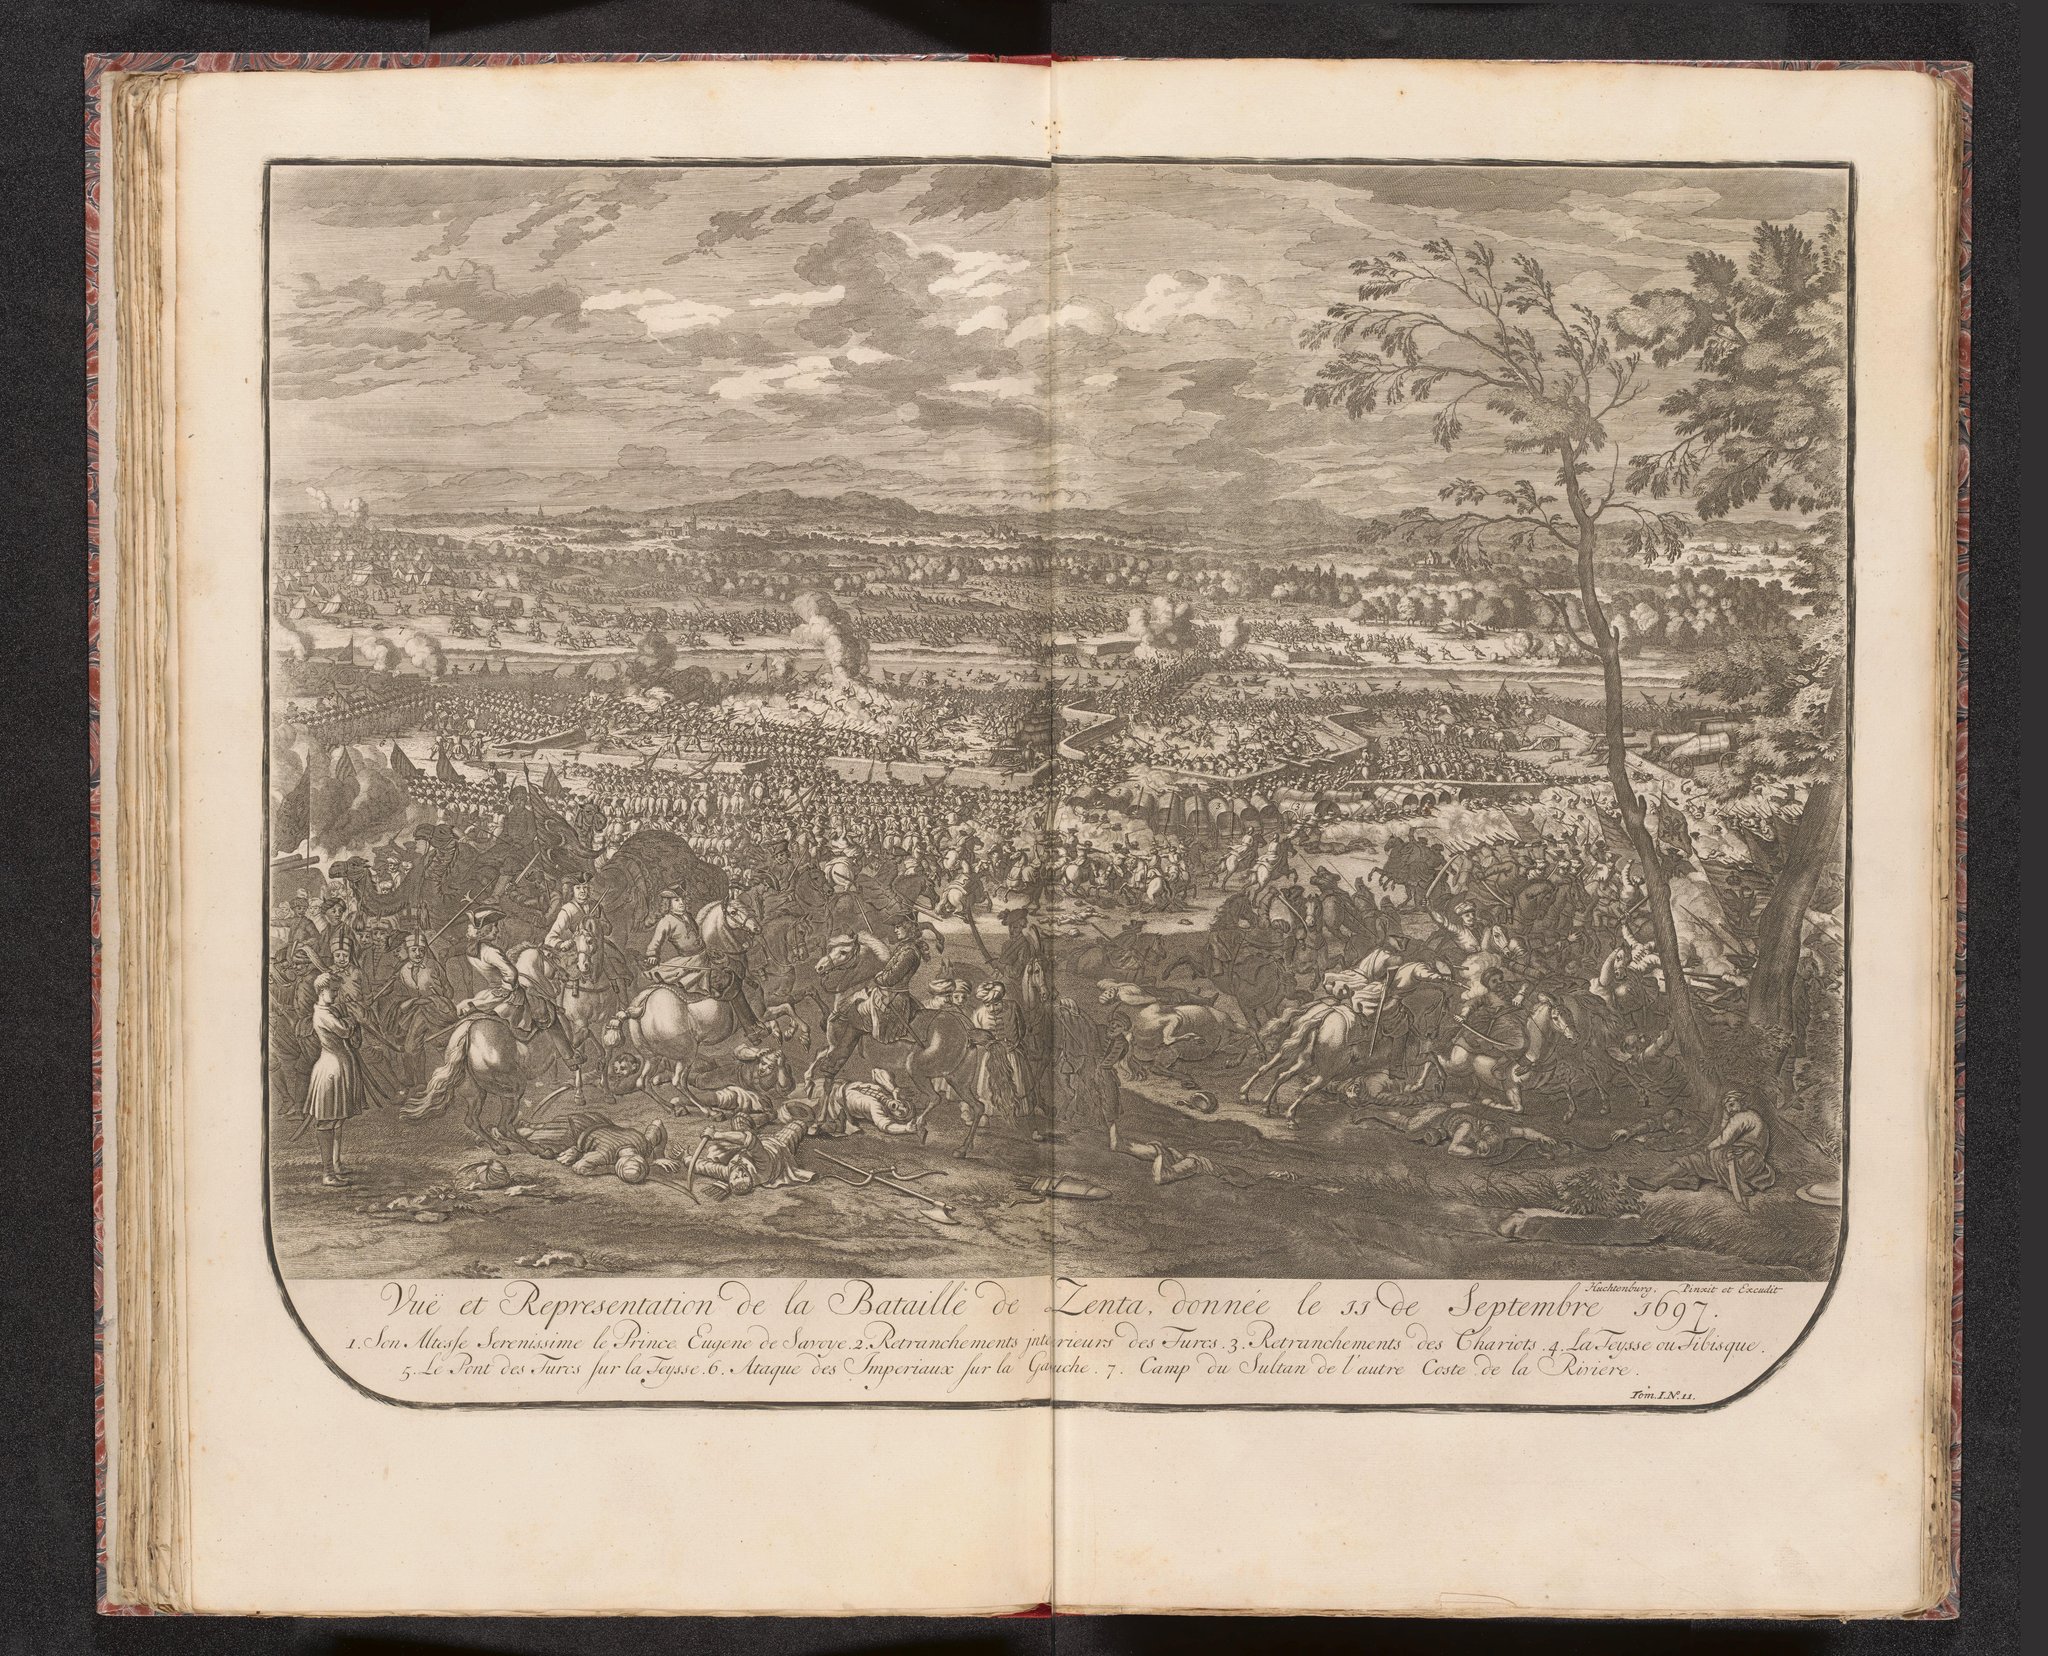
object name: history print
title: Vuë et Representation de la Bataille de Zenta, donnée le 11 de Septembre 1697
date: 1727-1729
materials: paper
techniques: engraving, etching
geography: the hague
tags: paris, eugenius van savoye, maps of separate countries or regions, battle (+ land forces)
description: De slag bij Senta (Zenta) aan de rivier Tisza in Servië op 11 september 1697 tussen de Turken en de keizerlijke troepen onder prins Eugenius van Savoye. Genummerd rechtsonder: Tom. I. No. 11. Illustratie in het eerste deel van: Jean du Mont, Oorlogskundige beschryving van de veldslagen en belegeringen, der drie ... wydvermaarde krygsoversten... den Prins Eugenius van Savoye, den ... Hertog van Marlborough, en den Prins van Oranje en Nassau-Vriesland, in de editie van 1729. Dit eerste deel is gewijd aan de daden van Eugenius, prins van Savoye.